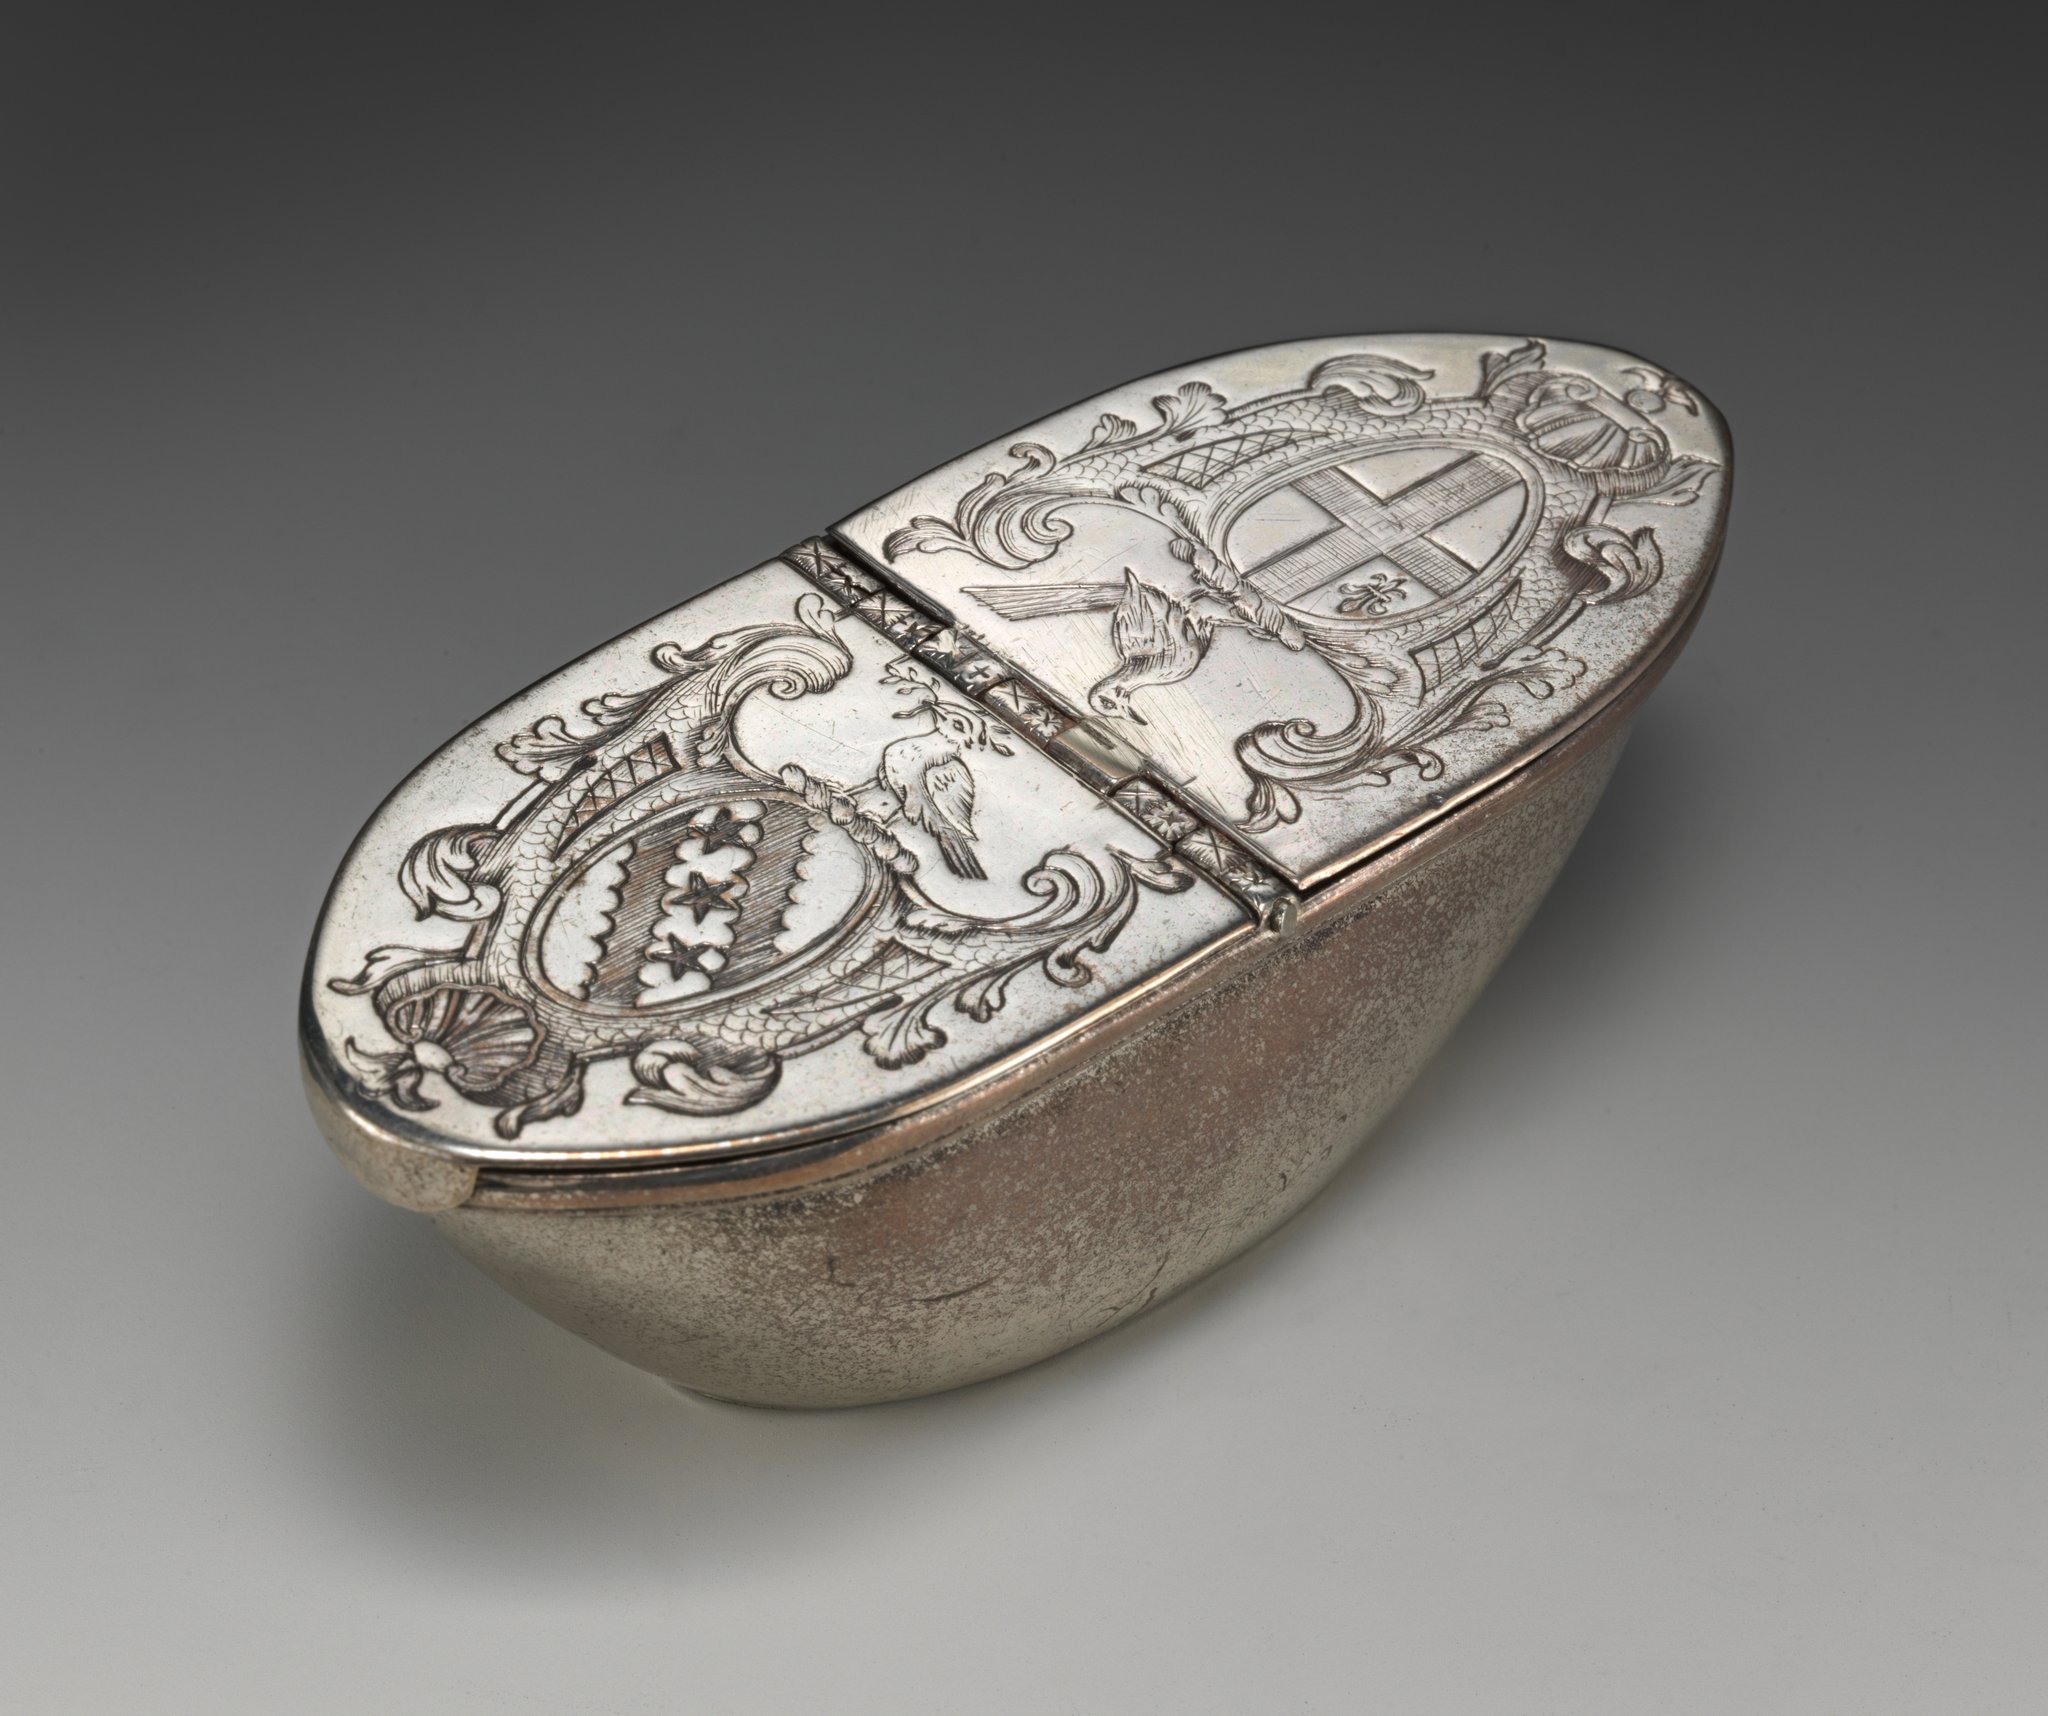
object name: nutmeg box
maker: james manners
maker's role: maker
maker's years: 1734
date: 1701-1750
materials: silver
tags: birds,insignia